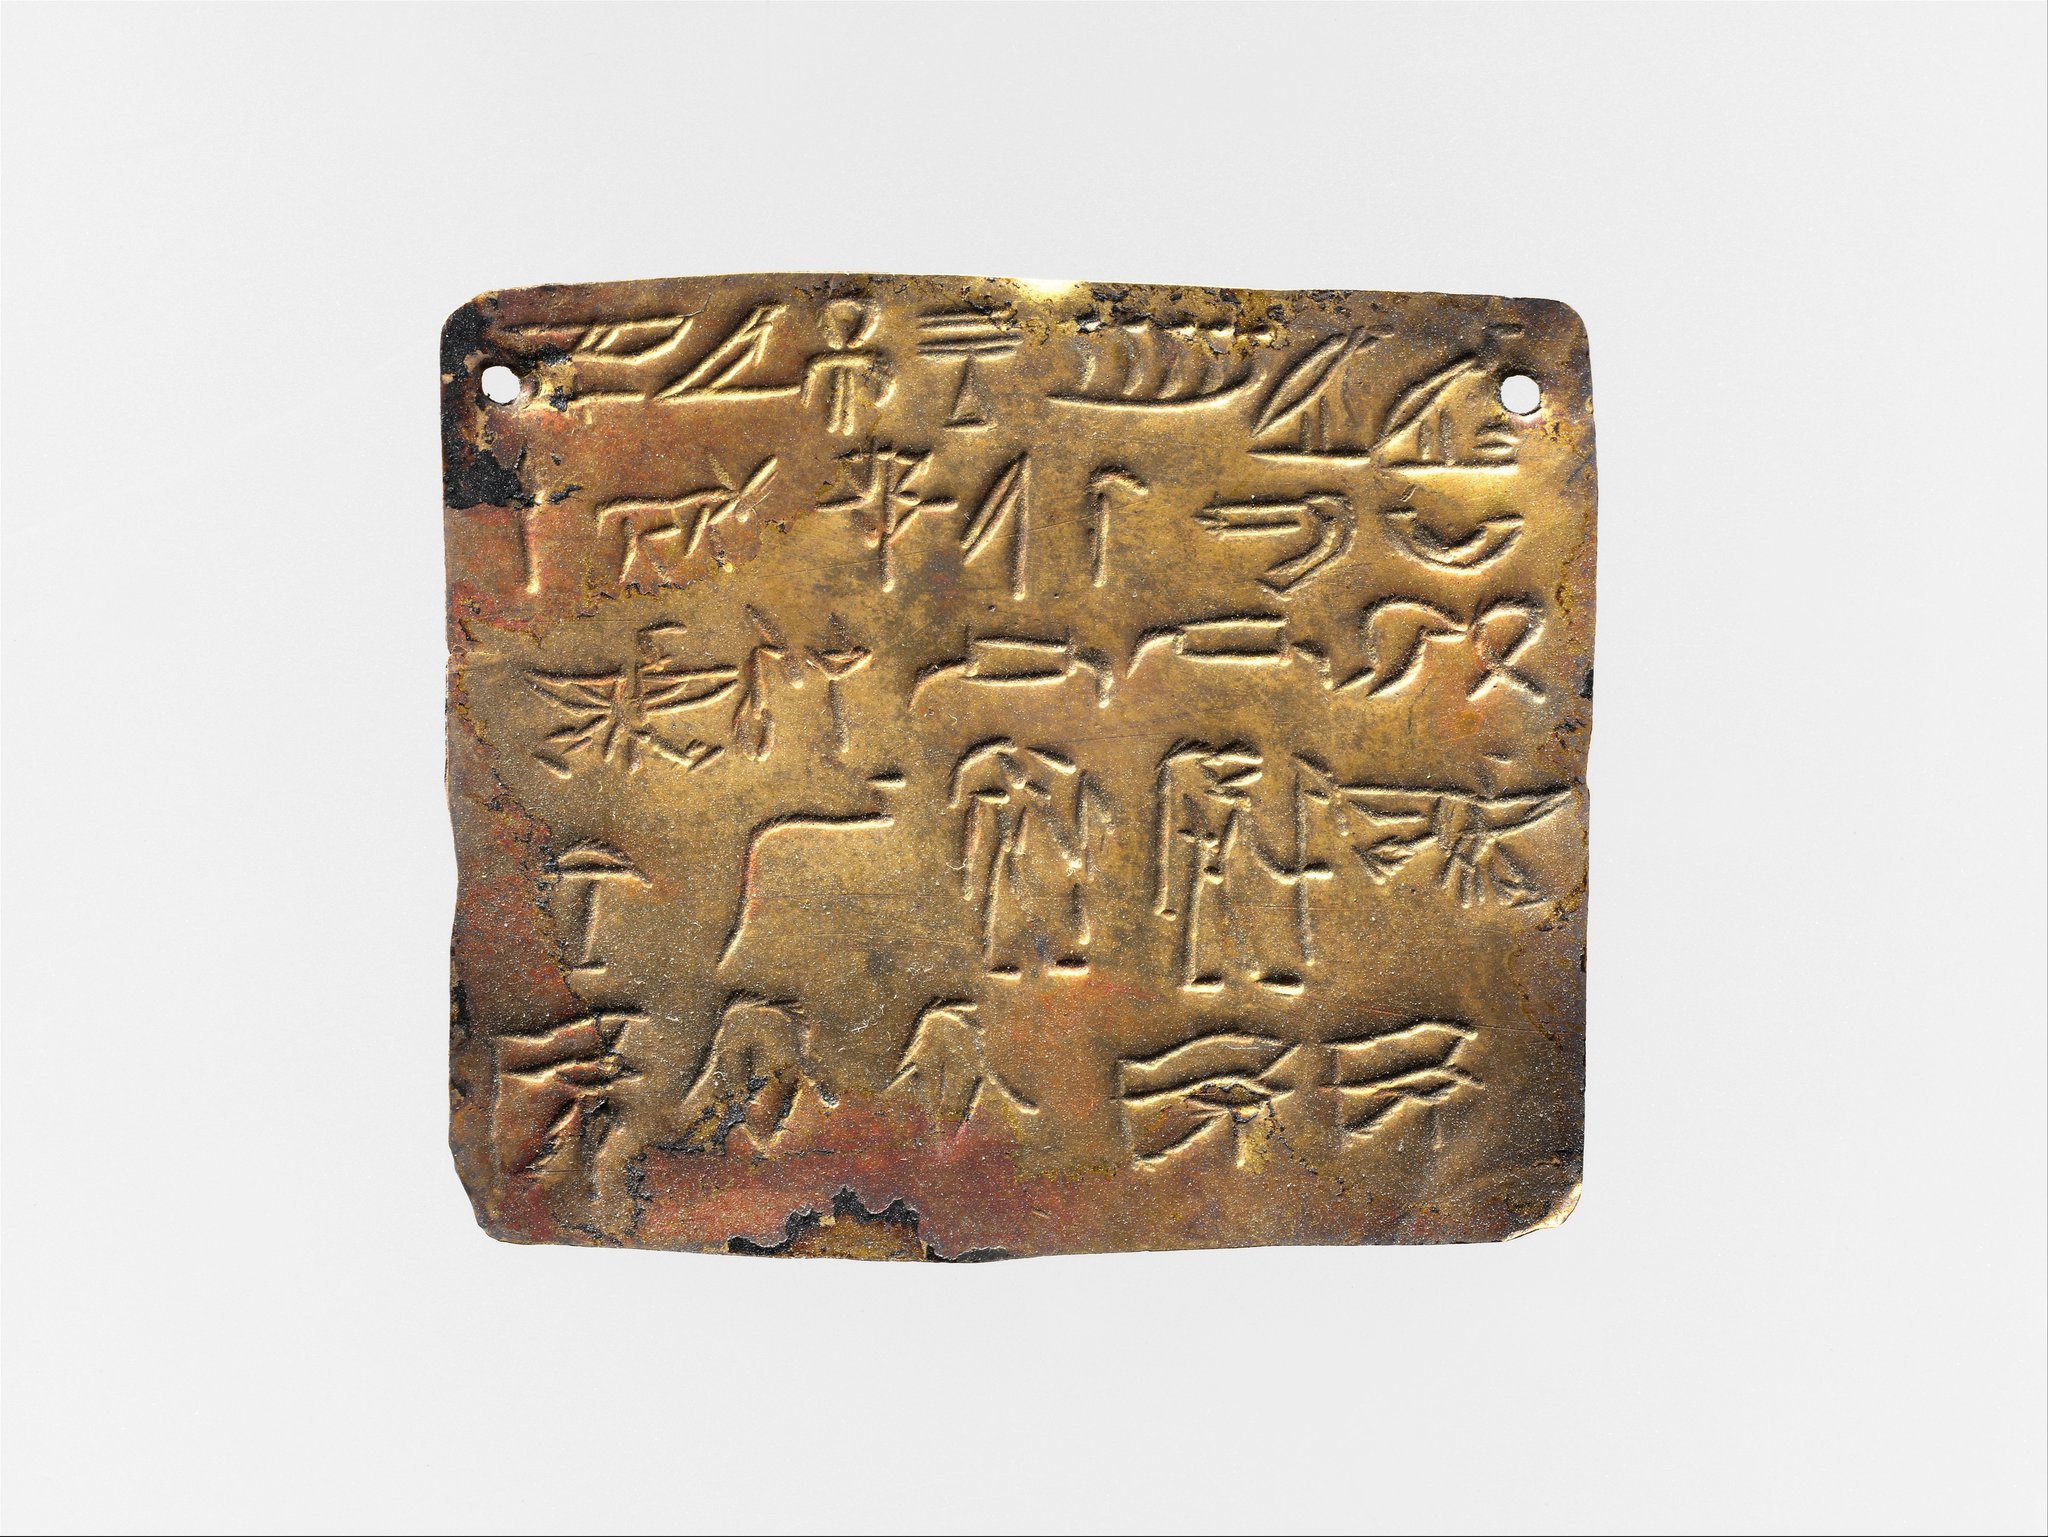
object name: amulet plaque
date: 664-630 BCE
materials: gold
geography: southern upper egypt